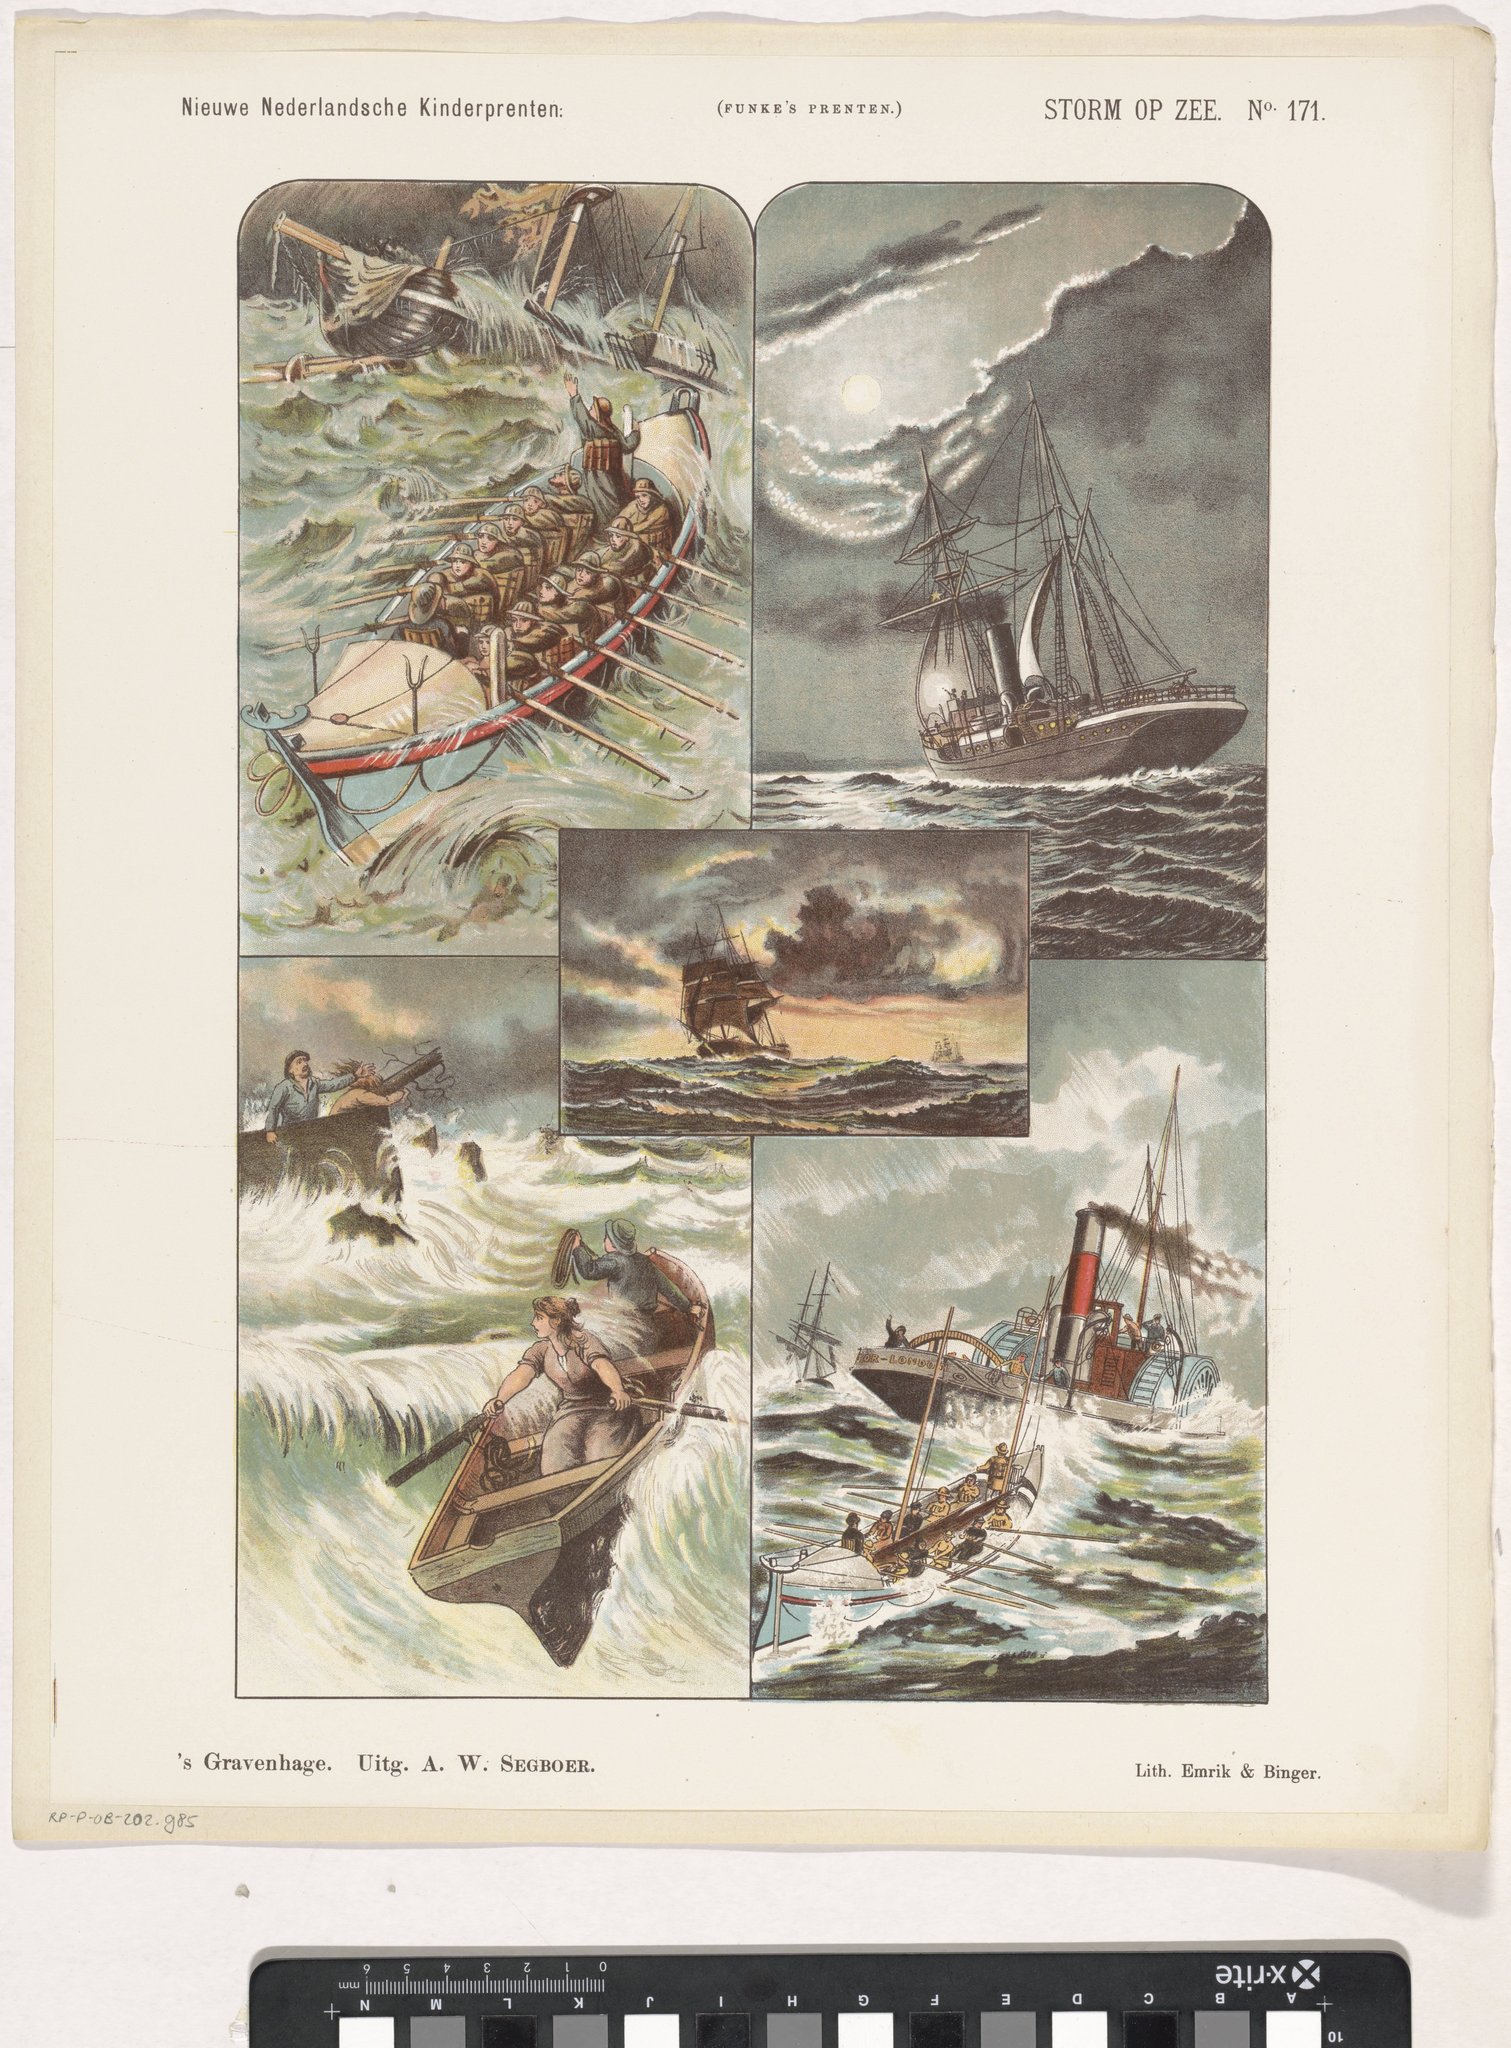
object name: popular print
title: Funke's prenten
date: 1903-1919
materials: paper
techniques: lithograph, letterpress printing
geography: the hague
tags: ships (in general), storm at sea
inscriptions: collector's mark: Lugt 2760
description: Blad met 5 voorstellingen van schepen tijdens een storm op zee. Genummerd rechtsboven: No. 171.